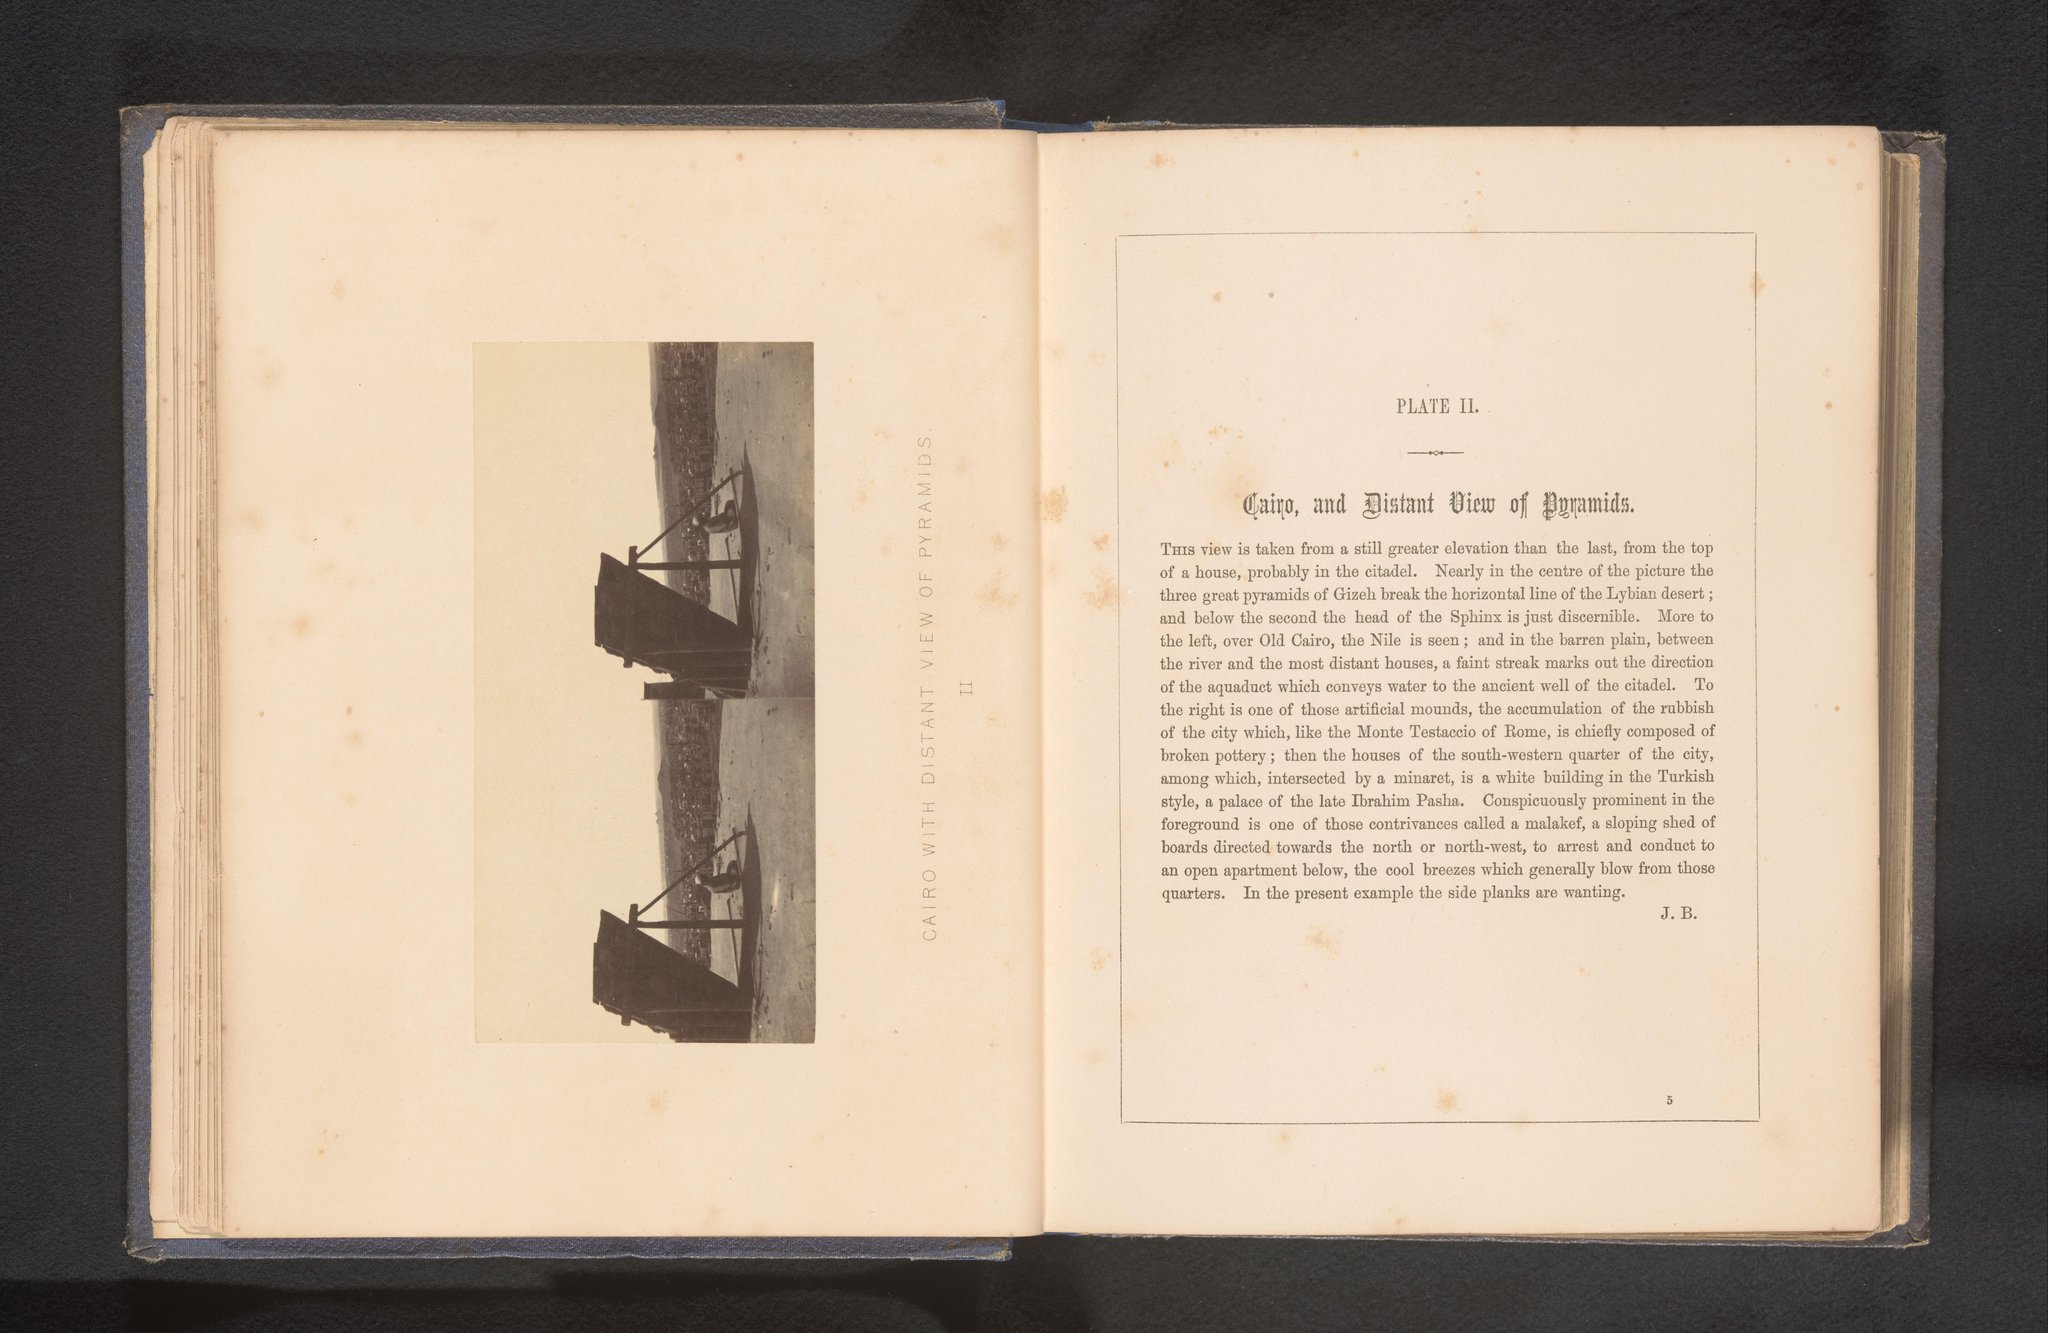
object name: page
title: Uitzicht op Caïro met in de verte piramiden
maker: francis frith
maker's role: publisher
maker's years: 1822-1898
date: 1857-1862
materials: photographic support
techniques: albumen print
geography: cairo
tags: city-view in general; 'veduta', egyptian pyramids (wonder of the world)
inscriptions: number: ‘II’